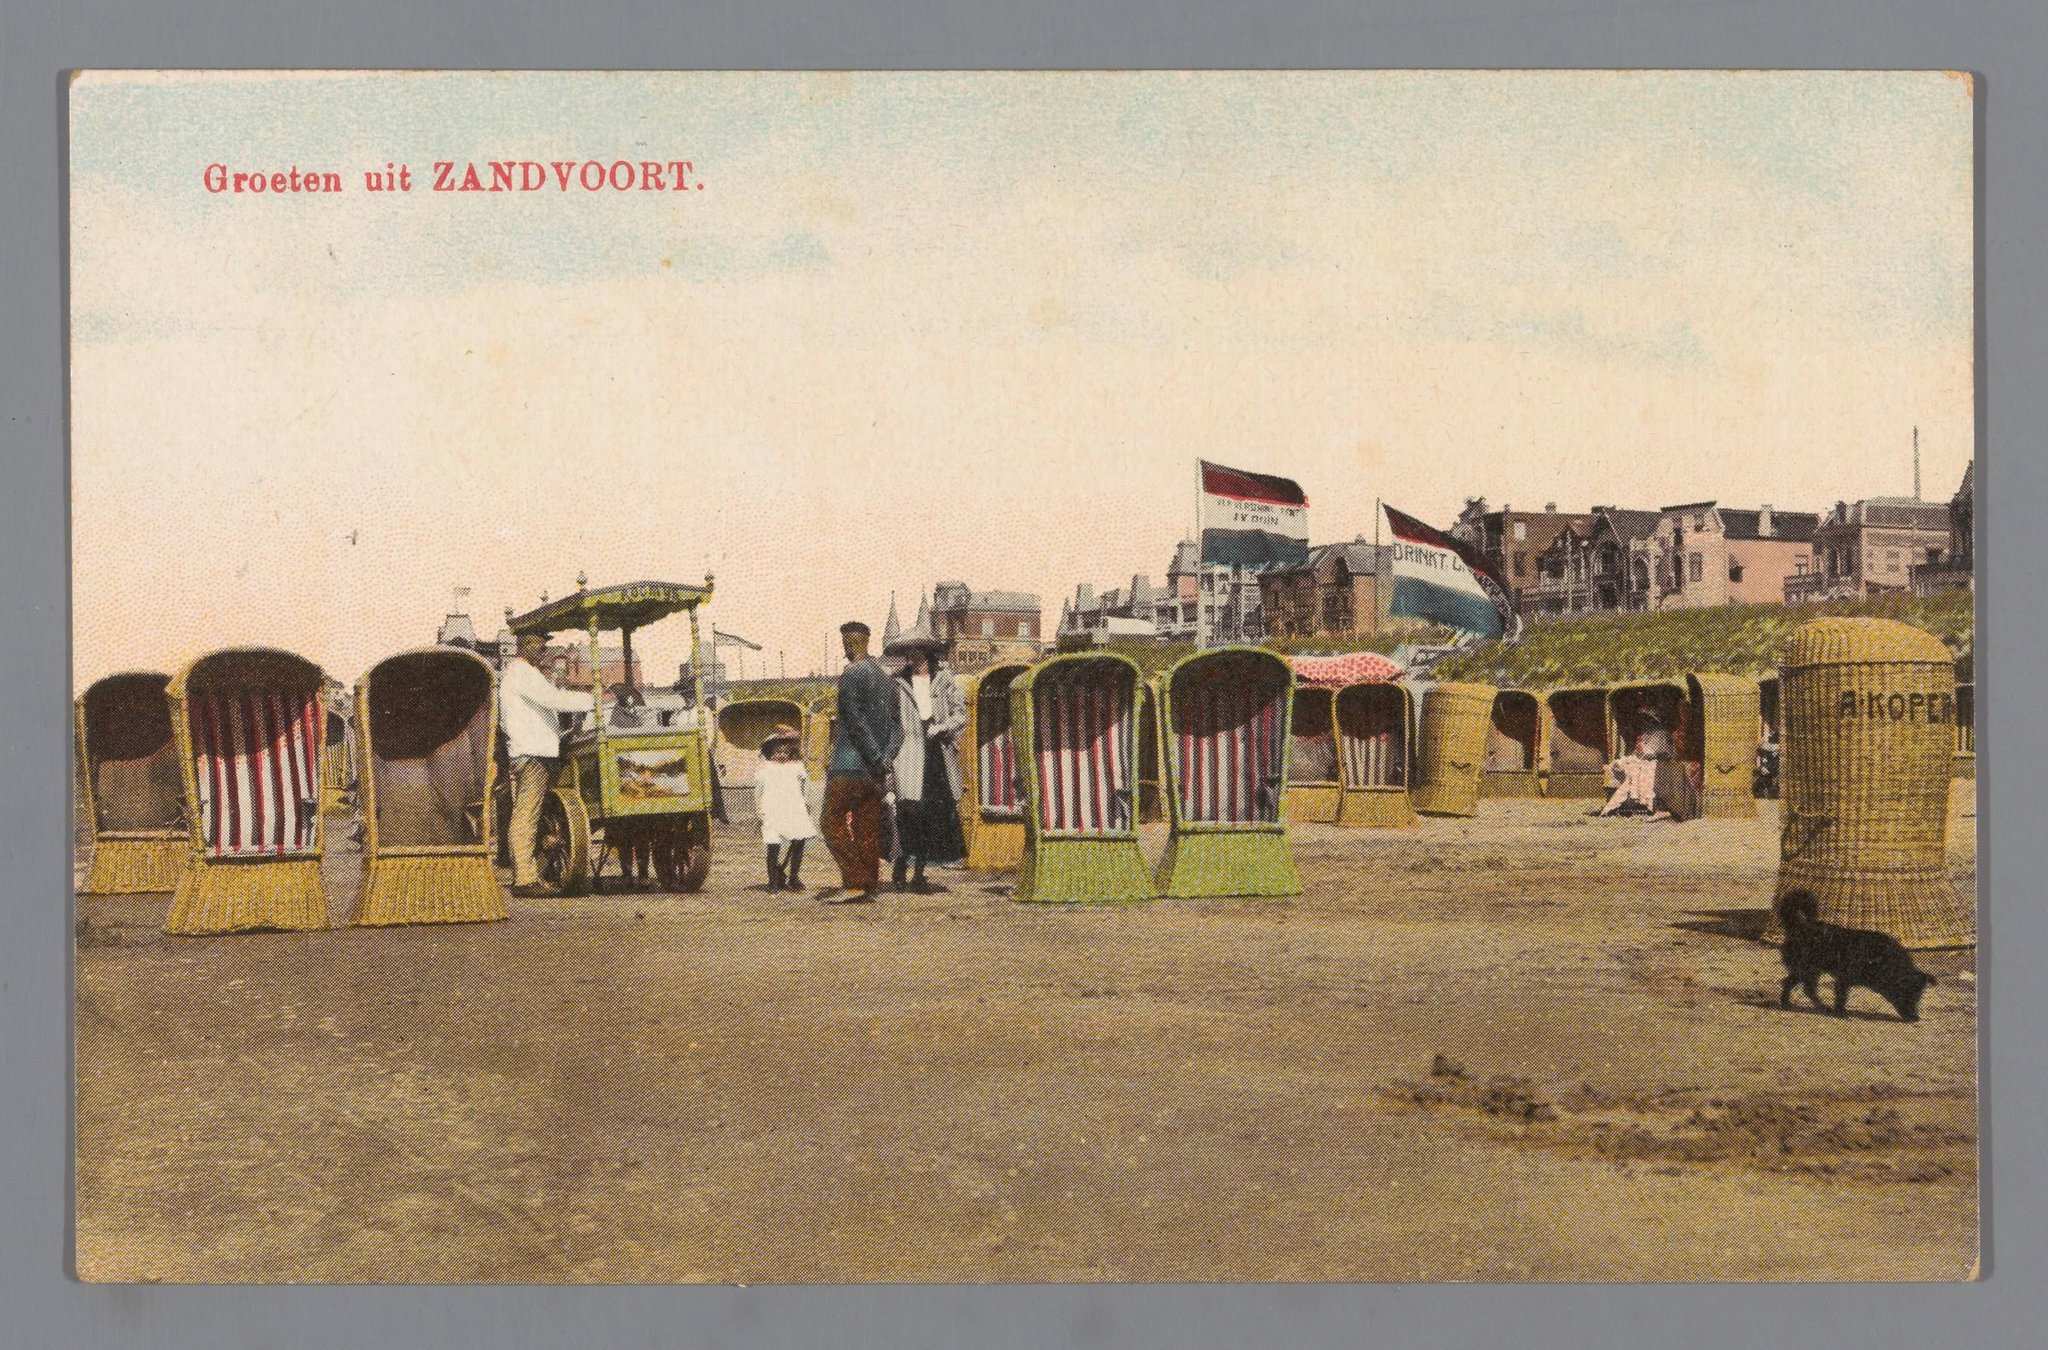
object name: ansichtkaart, prentbriefkaart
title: Groeten uit Zandvoort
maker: Anonymous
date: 1890-1920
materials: cardboard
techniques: writing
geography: zandvoort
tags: beach